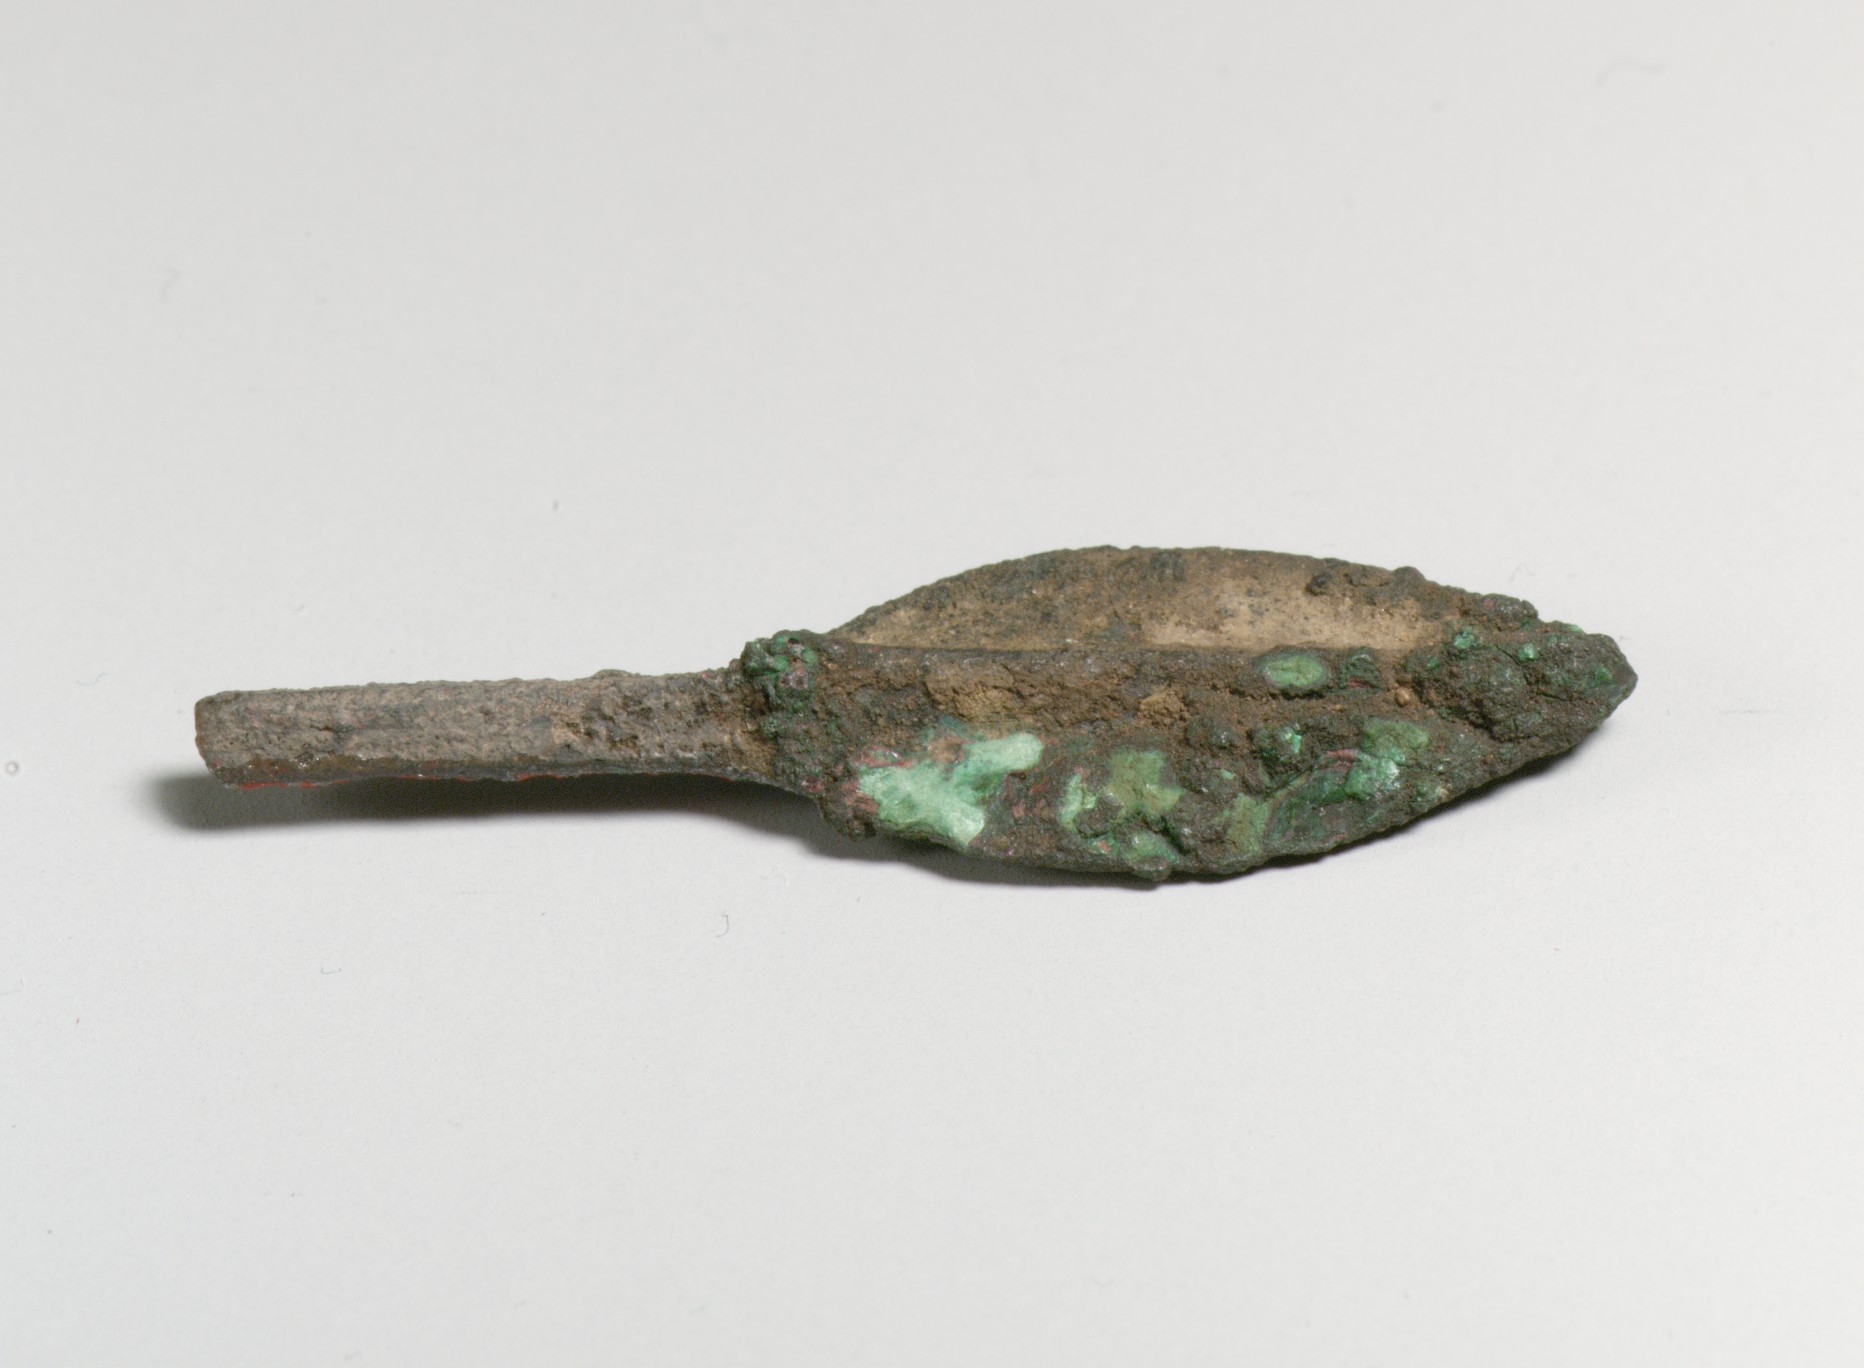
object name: arrowhead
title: Bronze arrowhead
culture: cypriot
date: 1600-1050 BCE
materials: bronze